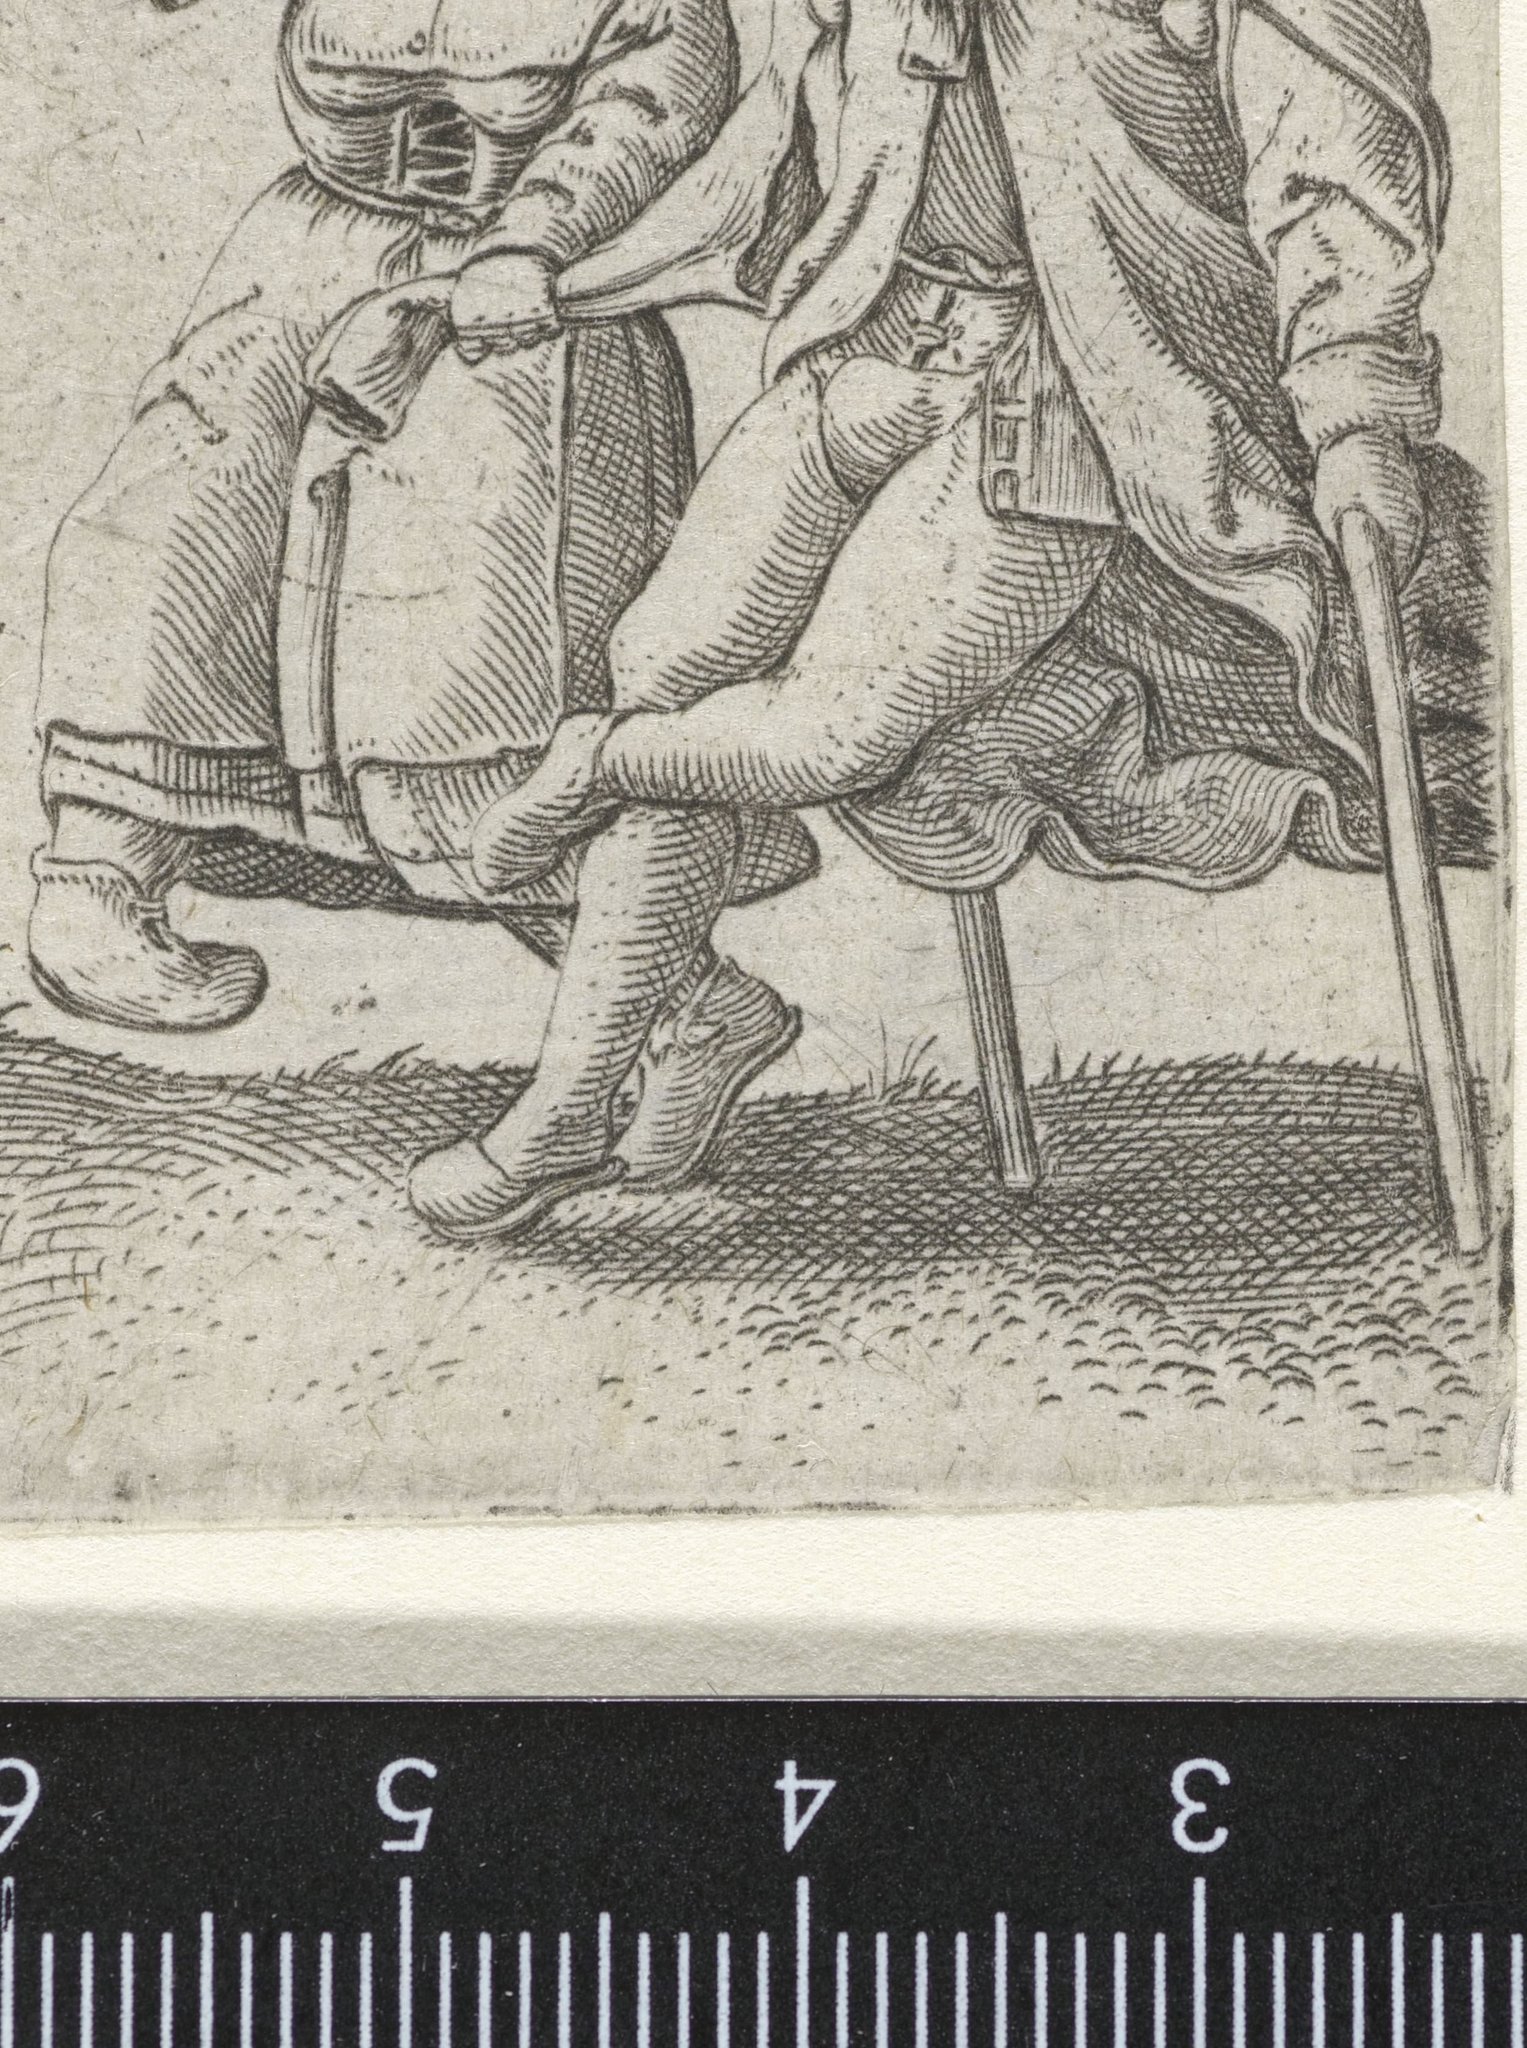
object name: print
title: Dansende man en vrouw gekleed als burgers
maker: cornelis massijs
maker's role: painter, print maker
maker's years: 1510-1557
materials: paper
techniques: engraving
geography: antwerp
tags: dancing, crutches, one pair dancing; man and woman dancing as a couple, person with a physical disability, social stratification, social groups, bourgeoisie, middle class, citizens, burghers, folk costume, regional costume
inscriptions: collector's mark: Lugt 2228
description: In de tijd waarin deze serie ontstond was 'kreupel' een generiek woord om een lichamelijke beperking aan het onderlichaam te beschrijven. Deze serie is sociale satire. De vrouw tilt een stok op en houdt de mouw van de man vast. De man draagt een baret en leunt op krukken.